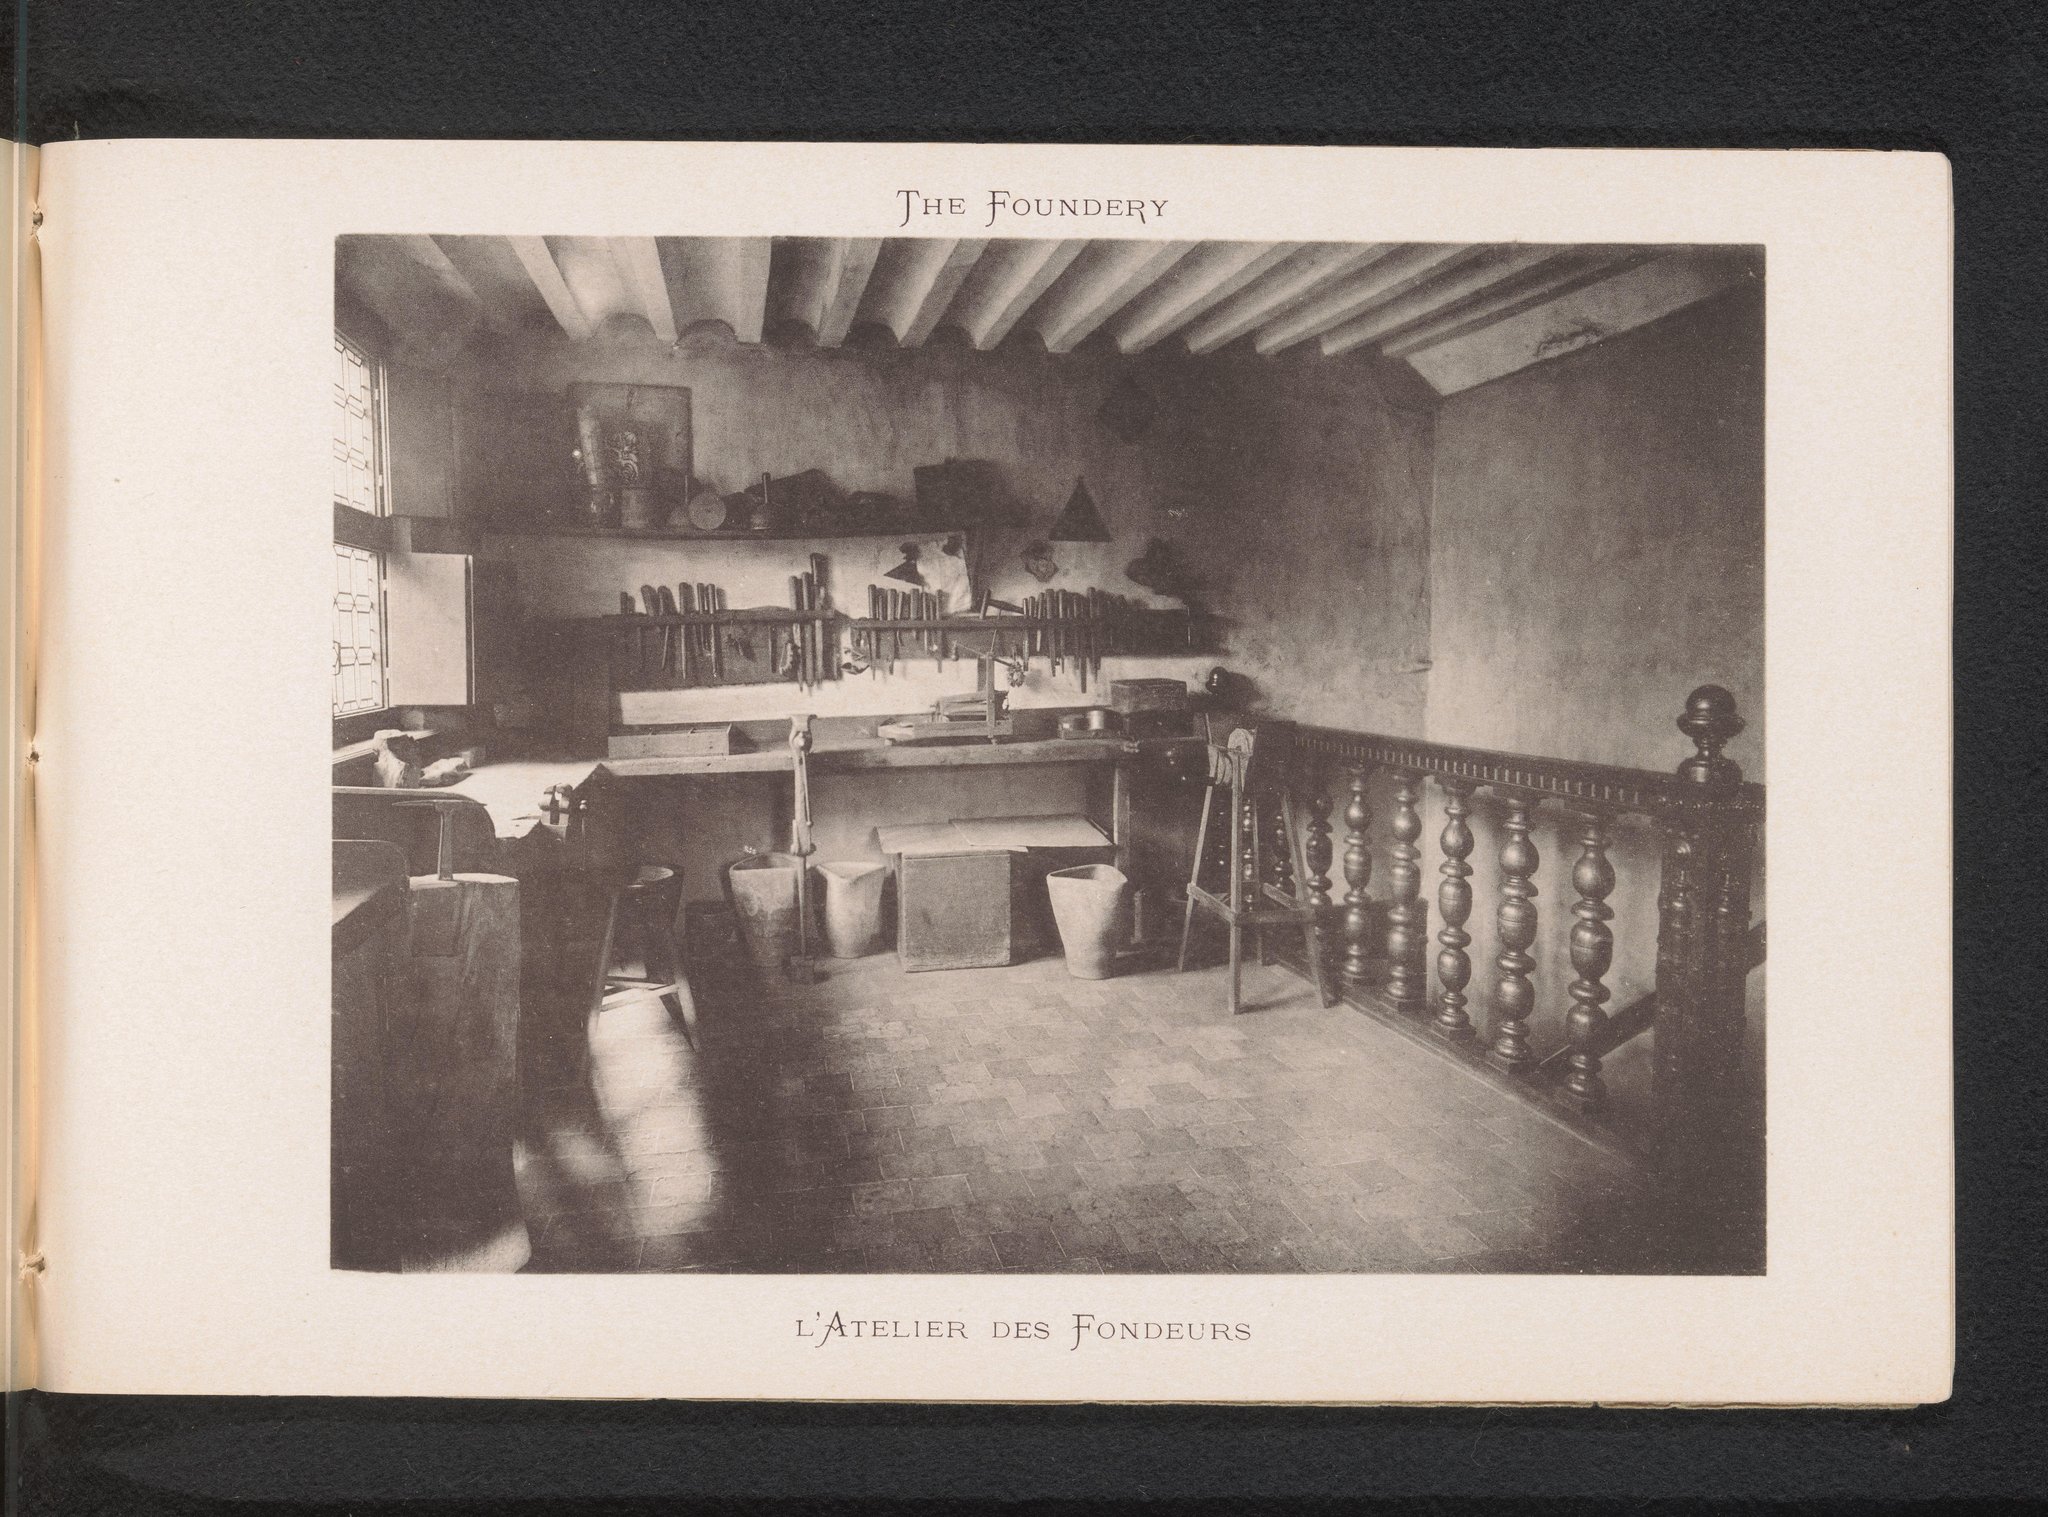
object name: page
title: The foundery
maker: Anonymous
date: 1892-1897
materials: paper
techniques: photograph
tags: workshop-interior